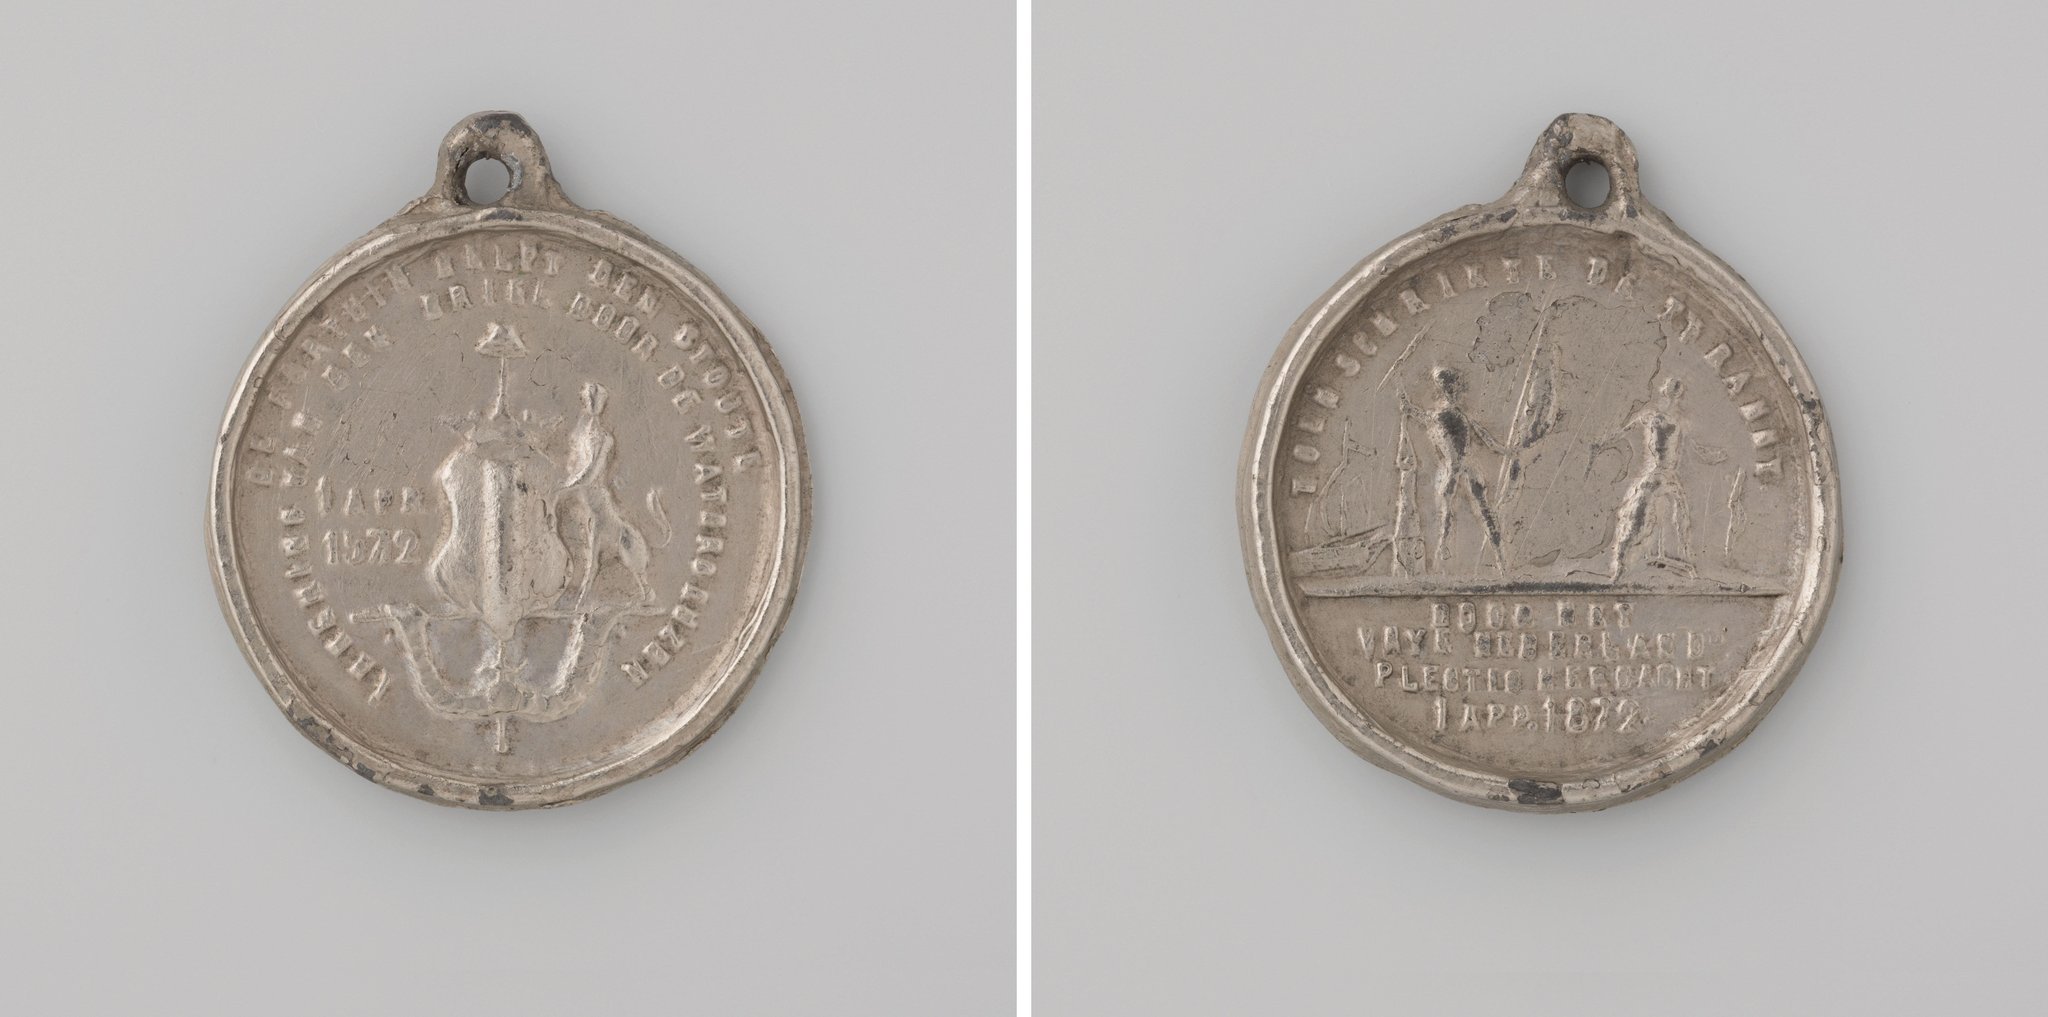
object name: history medal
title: Driehonderdjarige herdenking van de inname van Den Briel door de Watergeuzen 1872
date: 1872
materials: tin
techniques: casting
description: Gegoten tinnen penning met draagoog, op de voorzijde het gekroonde wapenschild van Den Briel, met rechts een centauer als drager, op een zwaard met vrijheidshoed, op een basis waaraan een tekstlint hangt, en naast de datum 1 APR 1572, met dubbel omschrift, op de keerzijde een watergeus met zwaard en vaandel die de Tyrannie, als vrouw met zwaard en vallend juk, verdrijft, met omschrift en afsnedetekst.